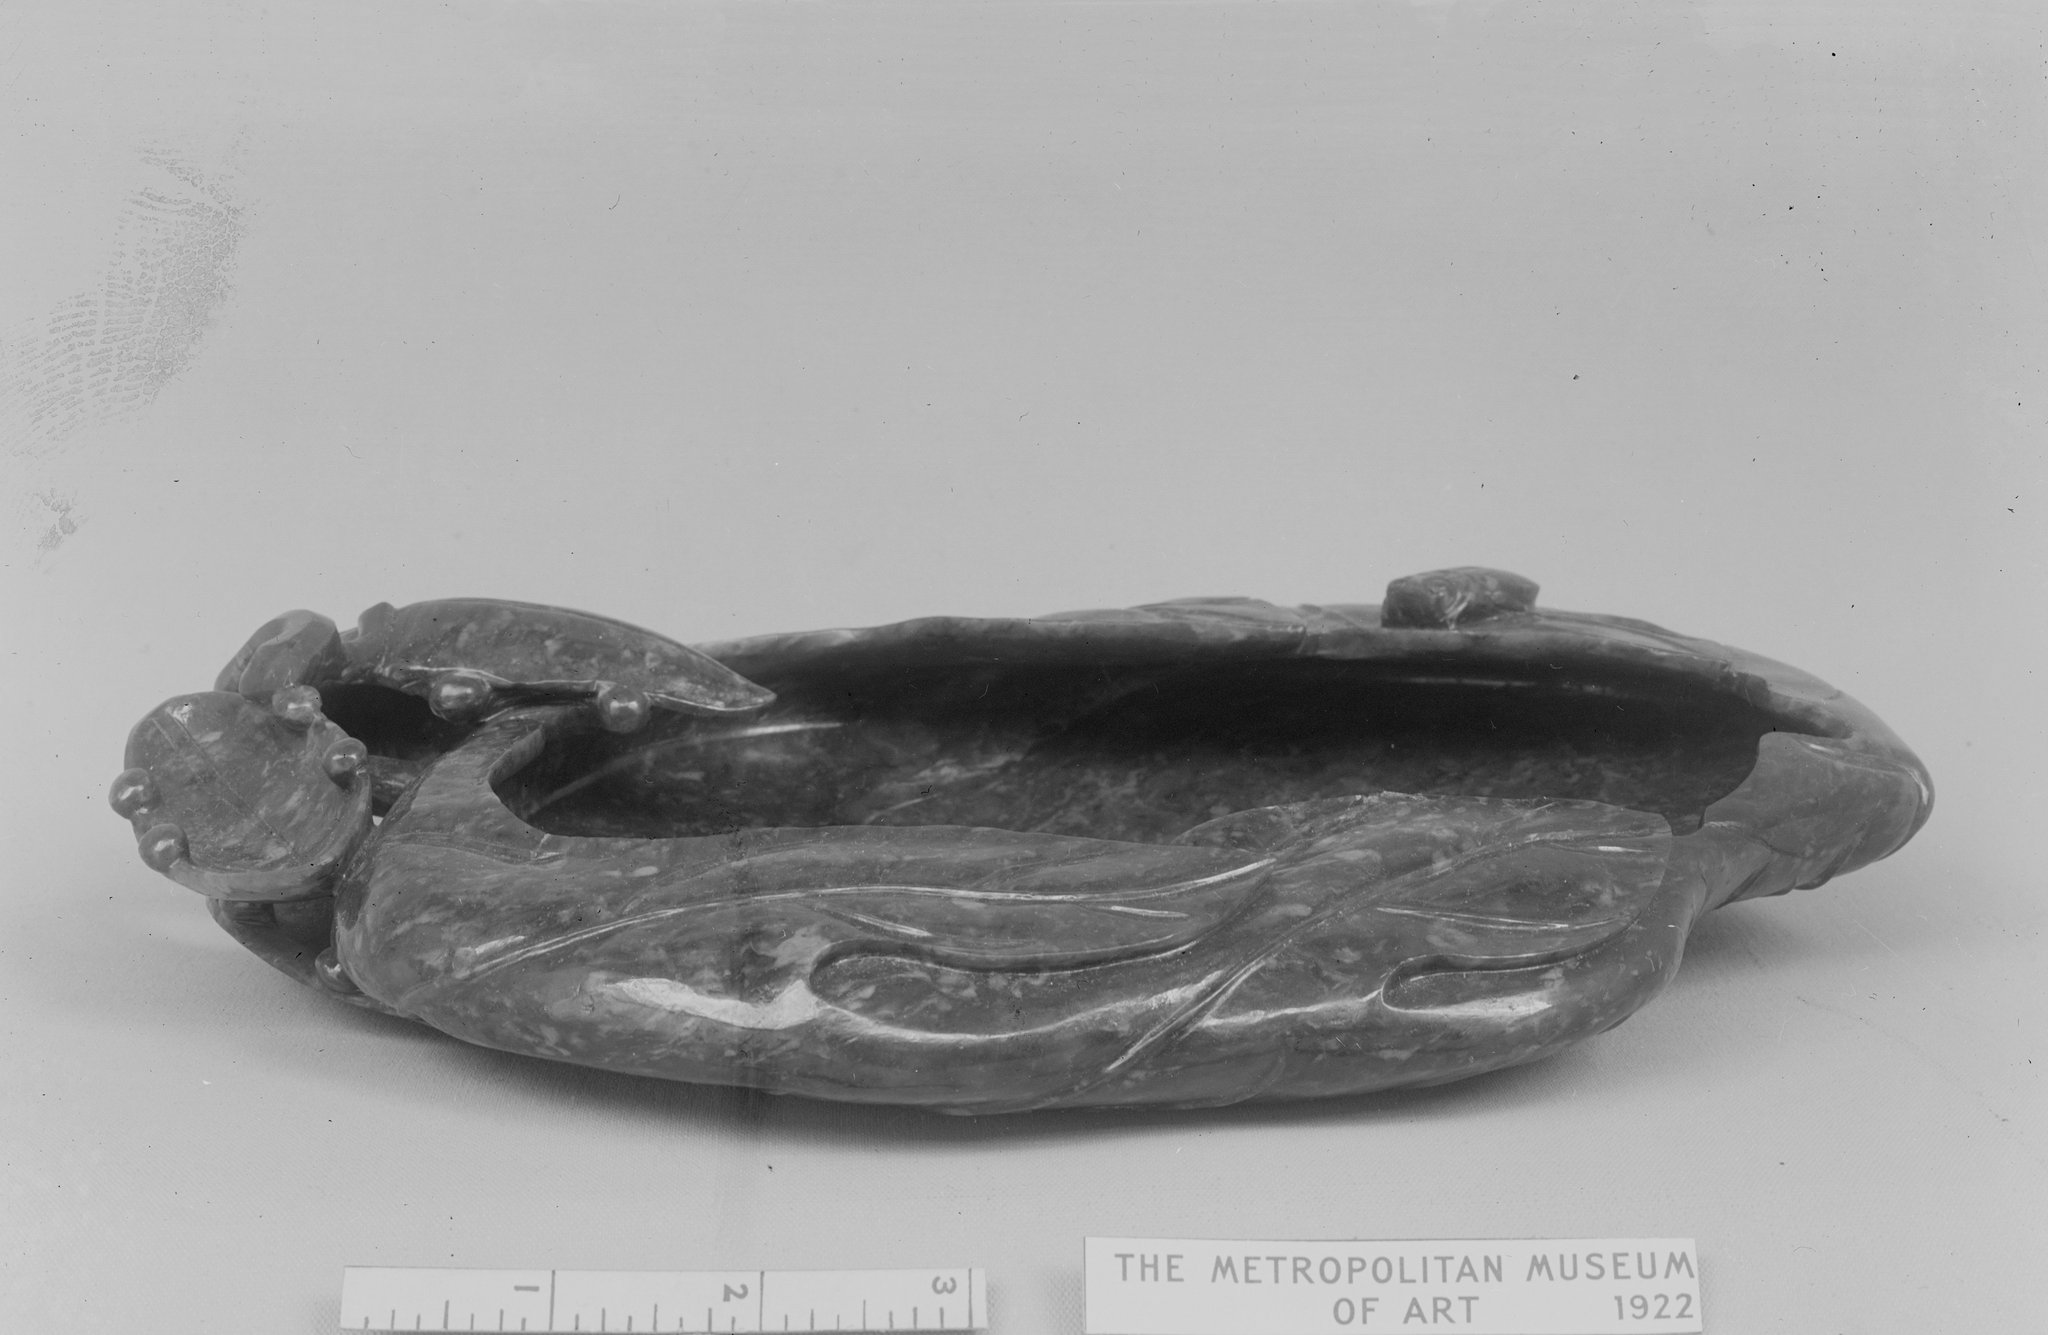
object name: tray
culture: chinese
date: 1736-1795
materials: jade